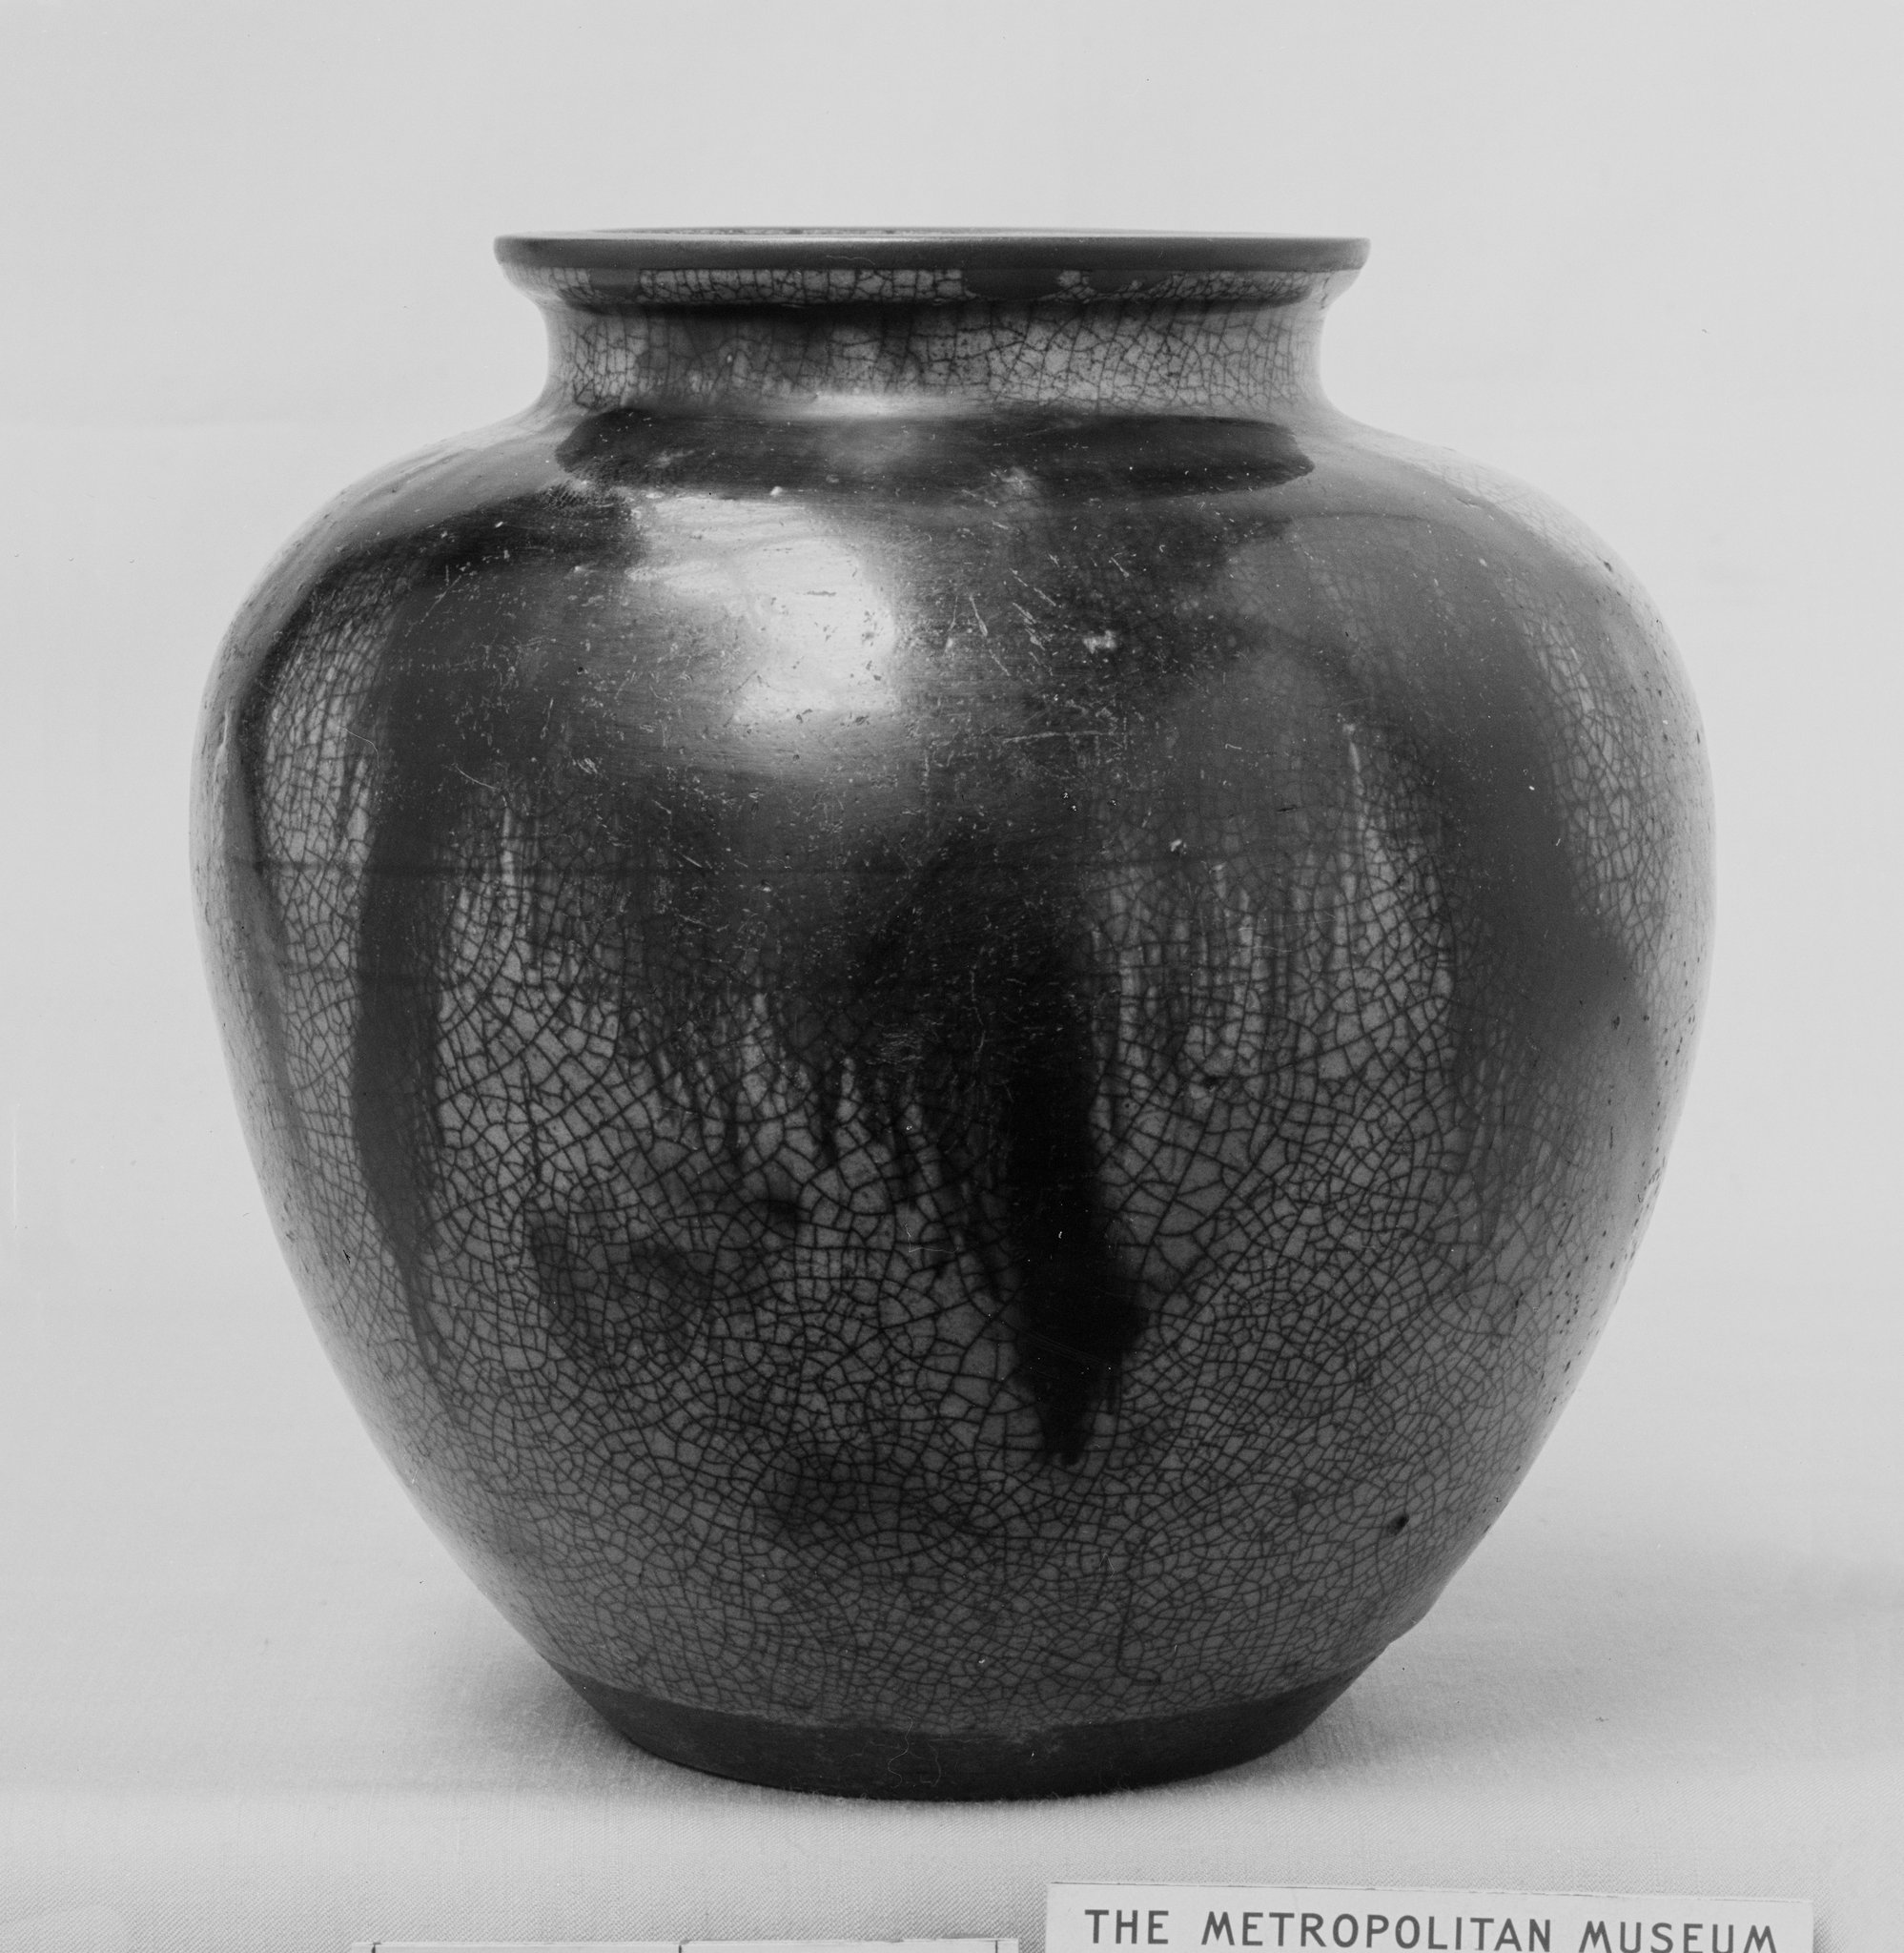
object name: jar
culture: japanese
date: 1801-1900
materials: clay, glaze